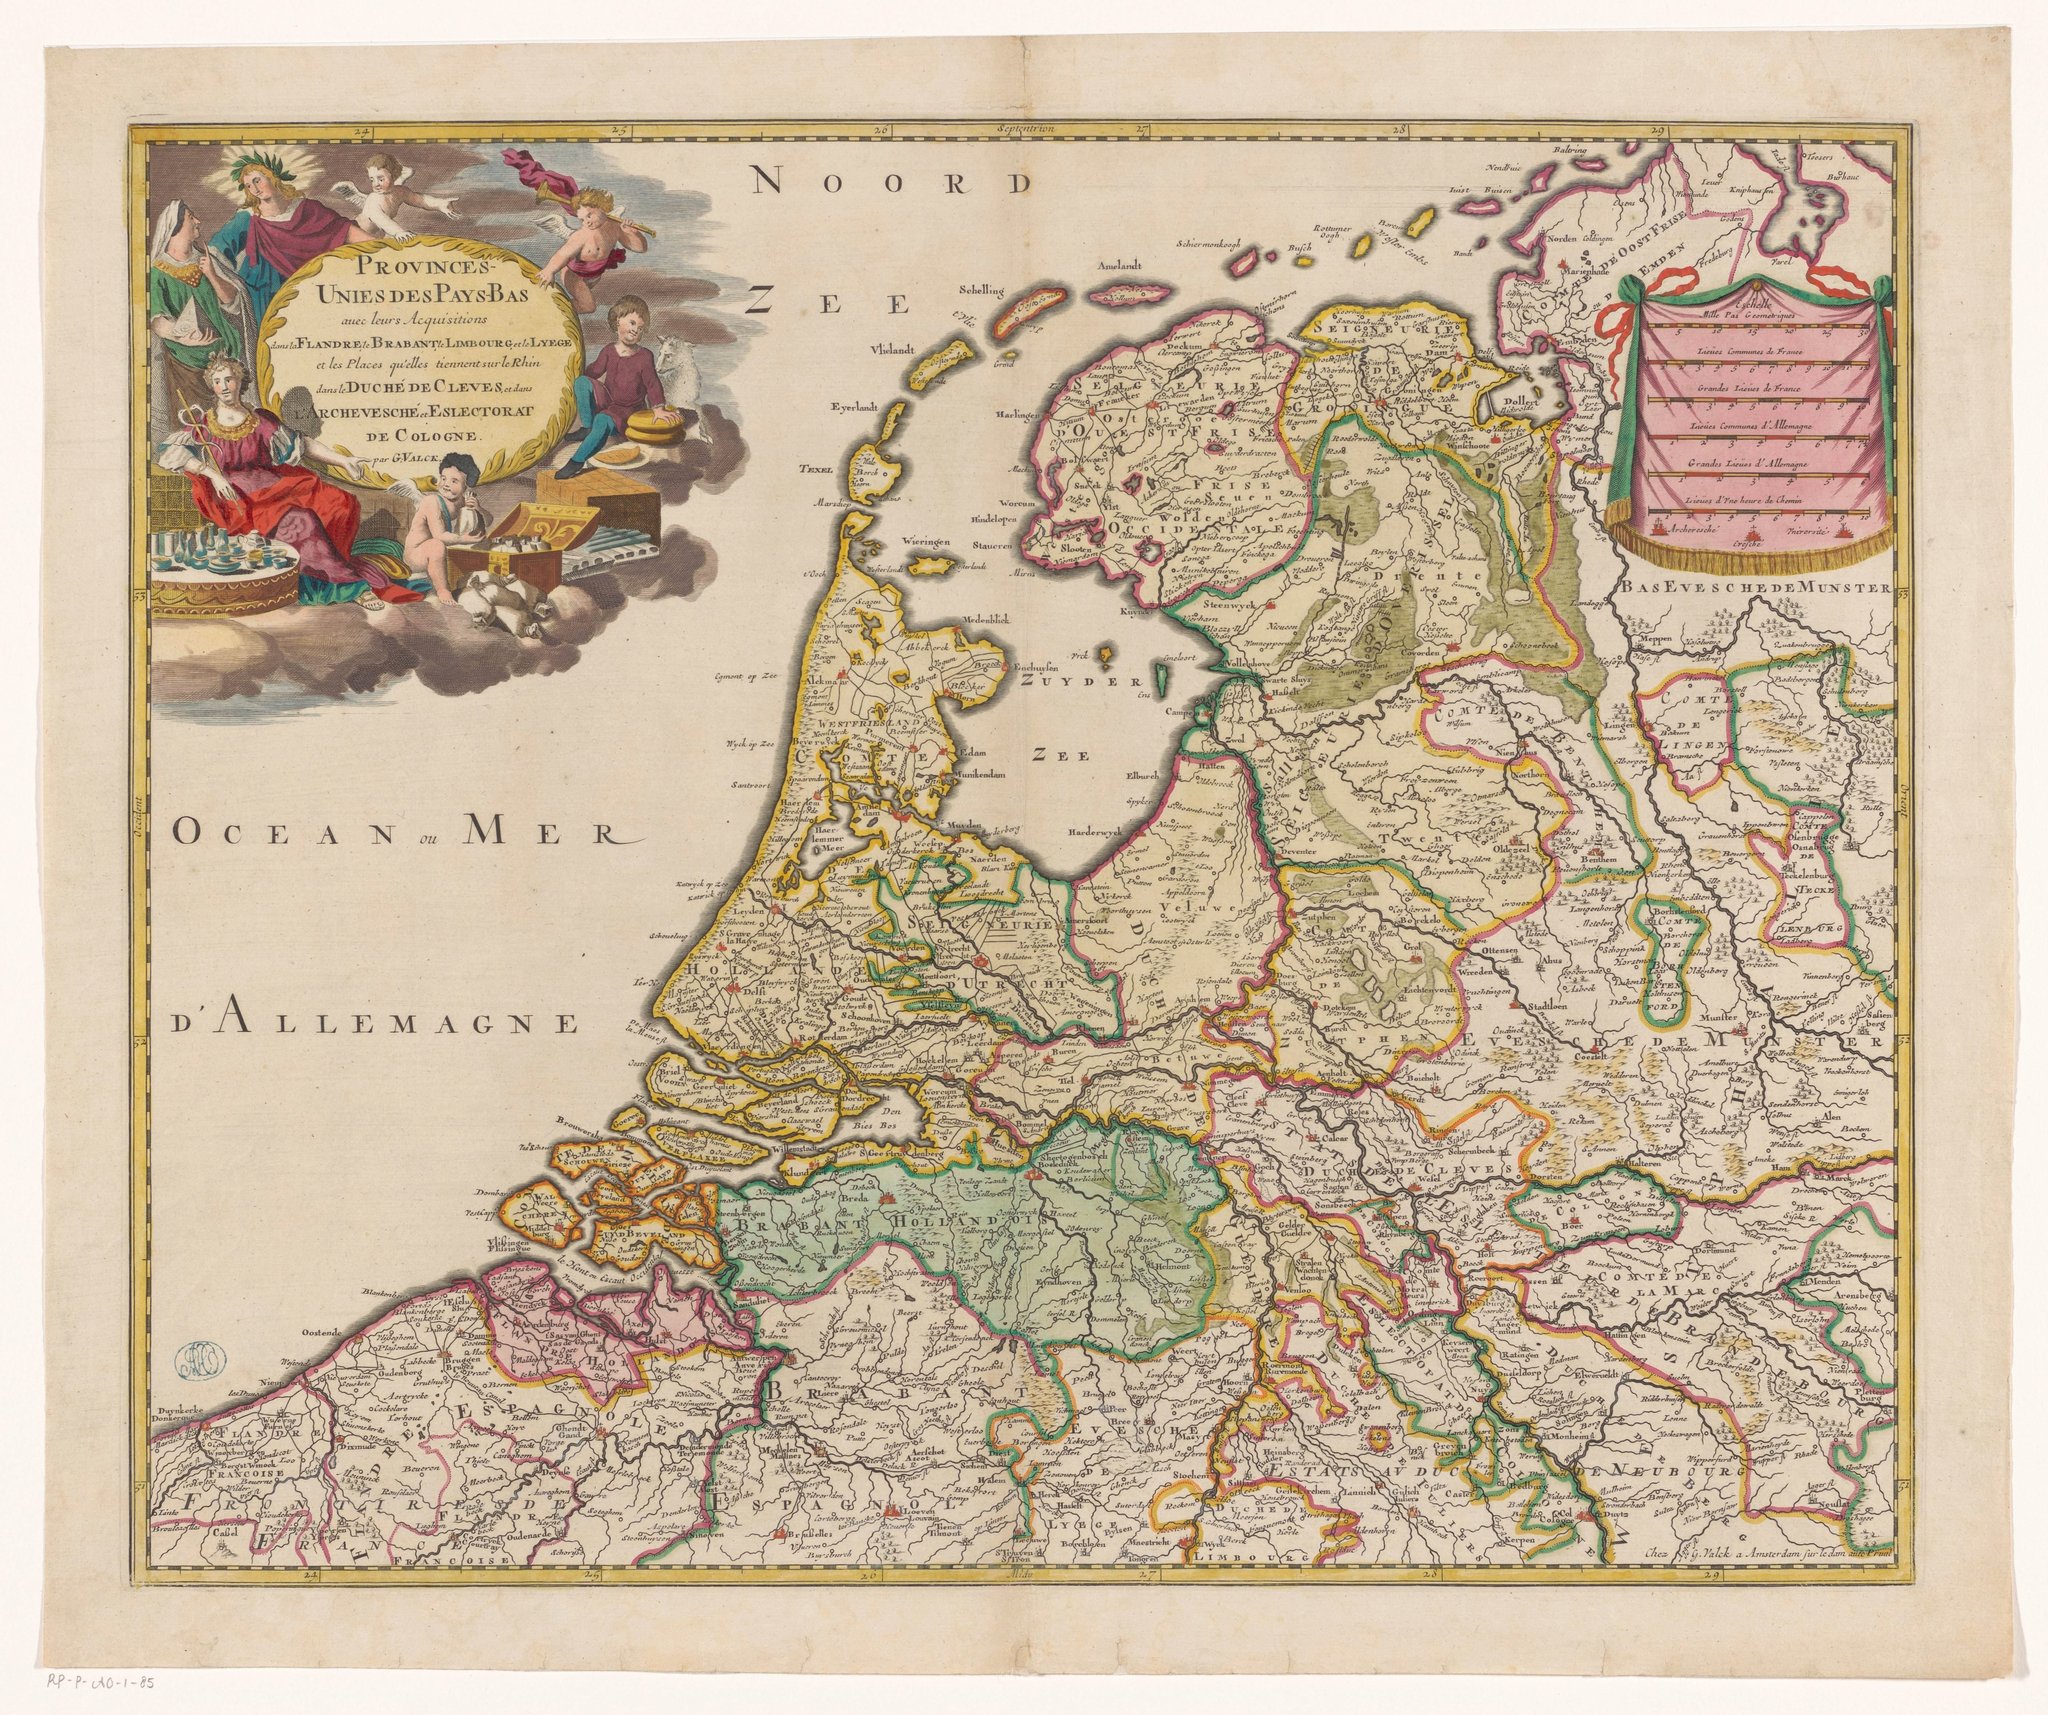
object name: print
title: Provinces-Unies des Pays-Bas avec leurs acquisitions dans la Flandre (...)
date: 1690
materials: paper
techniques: engraving, hand coloring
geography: amsterdam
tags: maps of separate countries or regions, netherlands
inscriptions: collector's mark: Lugt 195, collector's mark: Lugt 2228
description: Links titelcartouche met daaromheen een aantal figuren en producten die symbool staan voor de welvaart van de Republiek. Rechts legenda en schaalstok: Mille pas geometriques, Lieües communes de France, en nog drie andere. Gradenverdeling langs de randen.